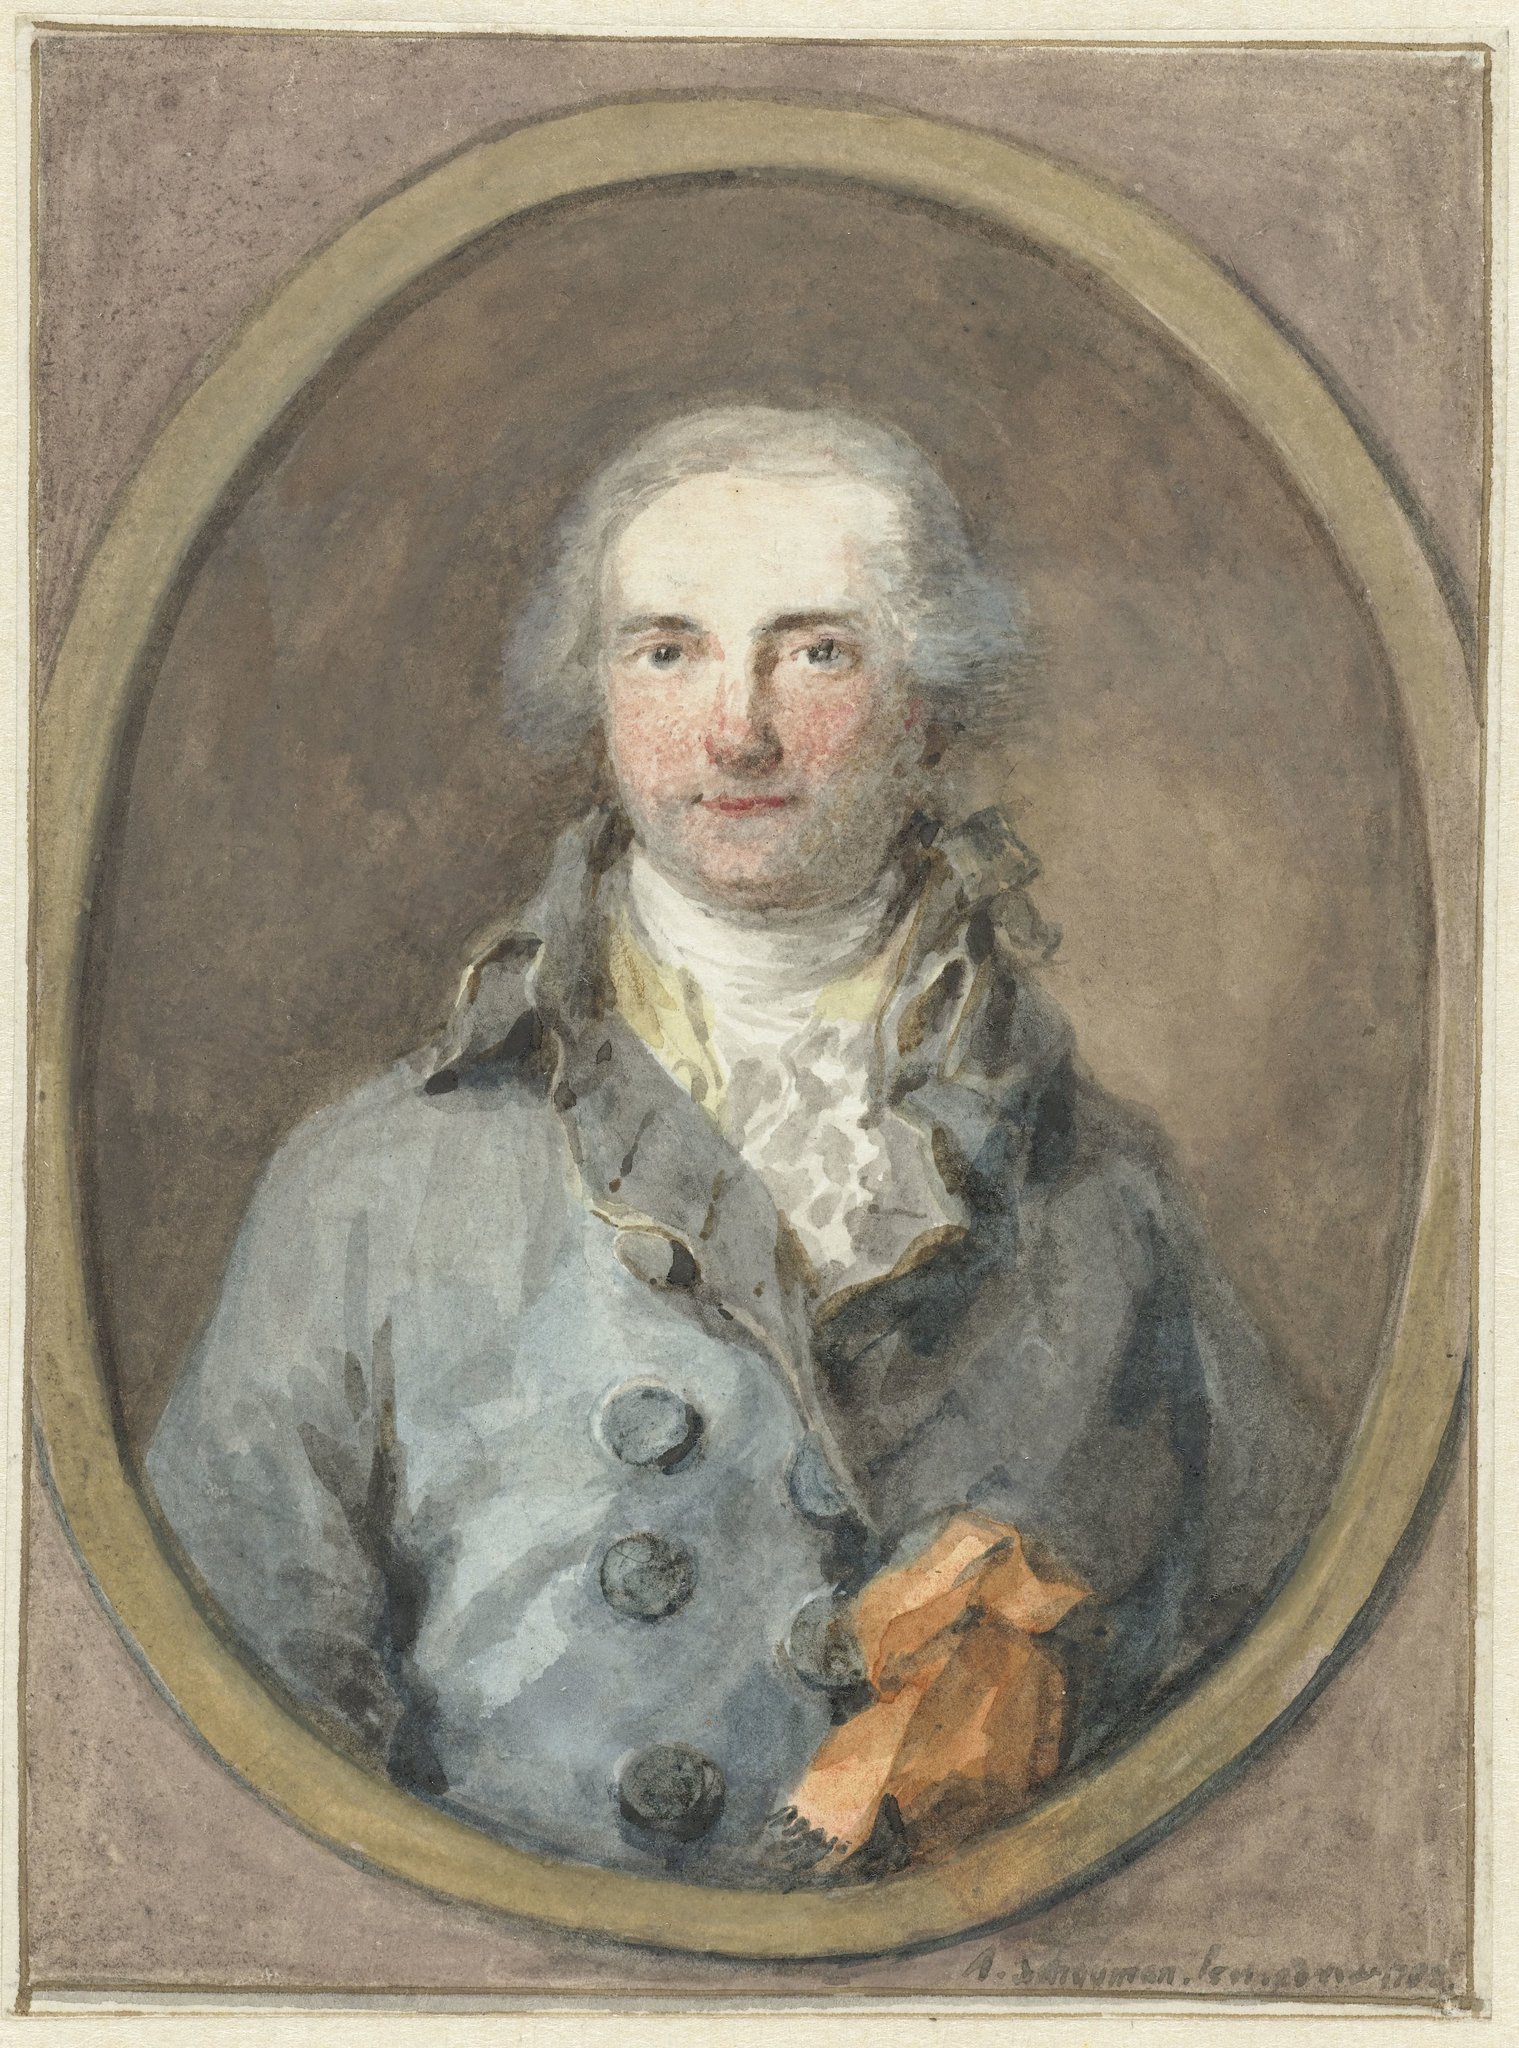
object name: watercolor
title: Portret van een heer in een ovaal kader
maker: aert schouman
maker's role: draughtsman, painter, print maker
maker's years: 1710-1792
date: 1788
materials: paper, watercolor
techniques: brush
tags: anonymous historical person portrayed alone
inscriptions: date